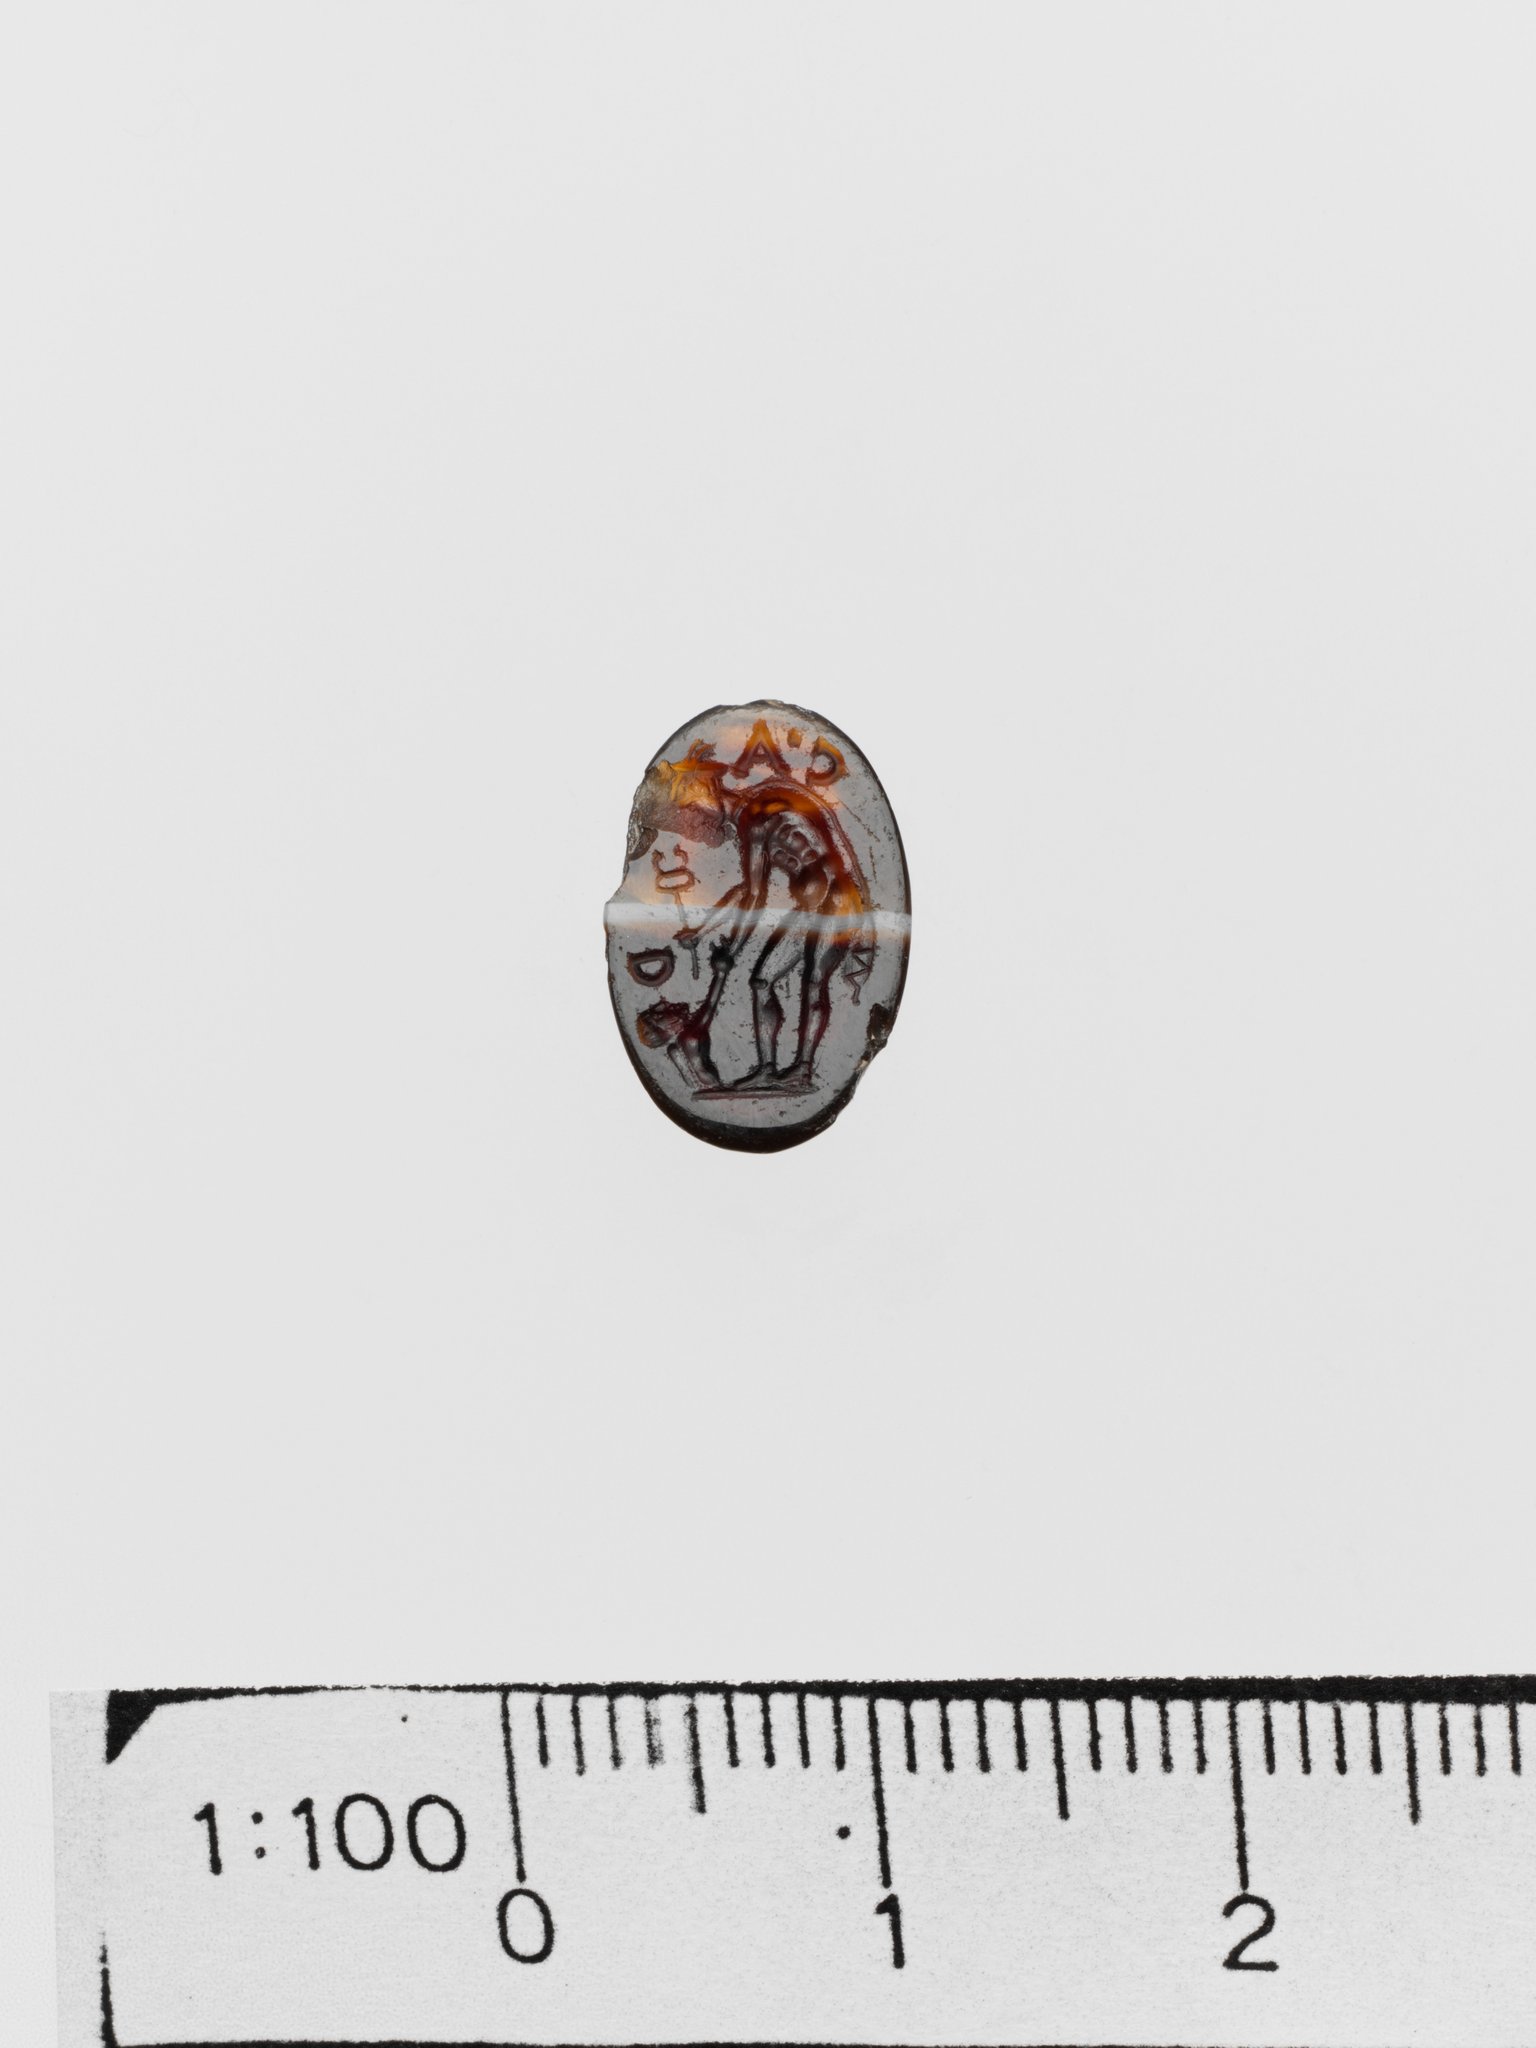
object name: intaglio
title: Banded agate ring stone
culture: italic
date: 300-101 BCE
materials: stone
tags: hermes